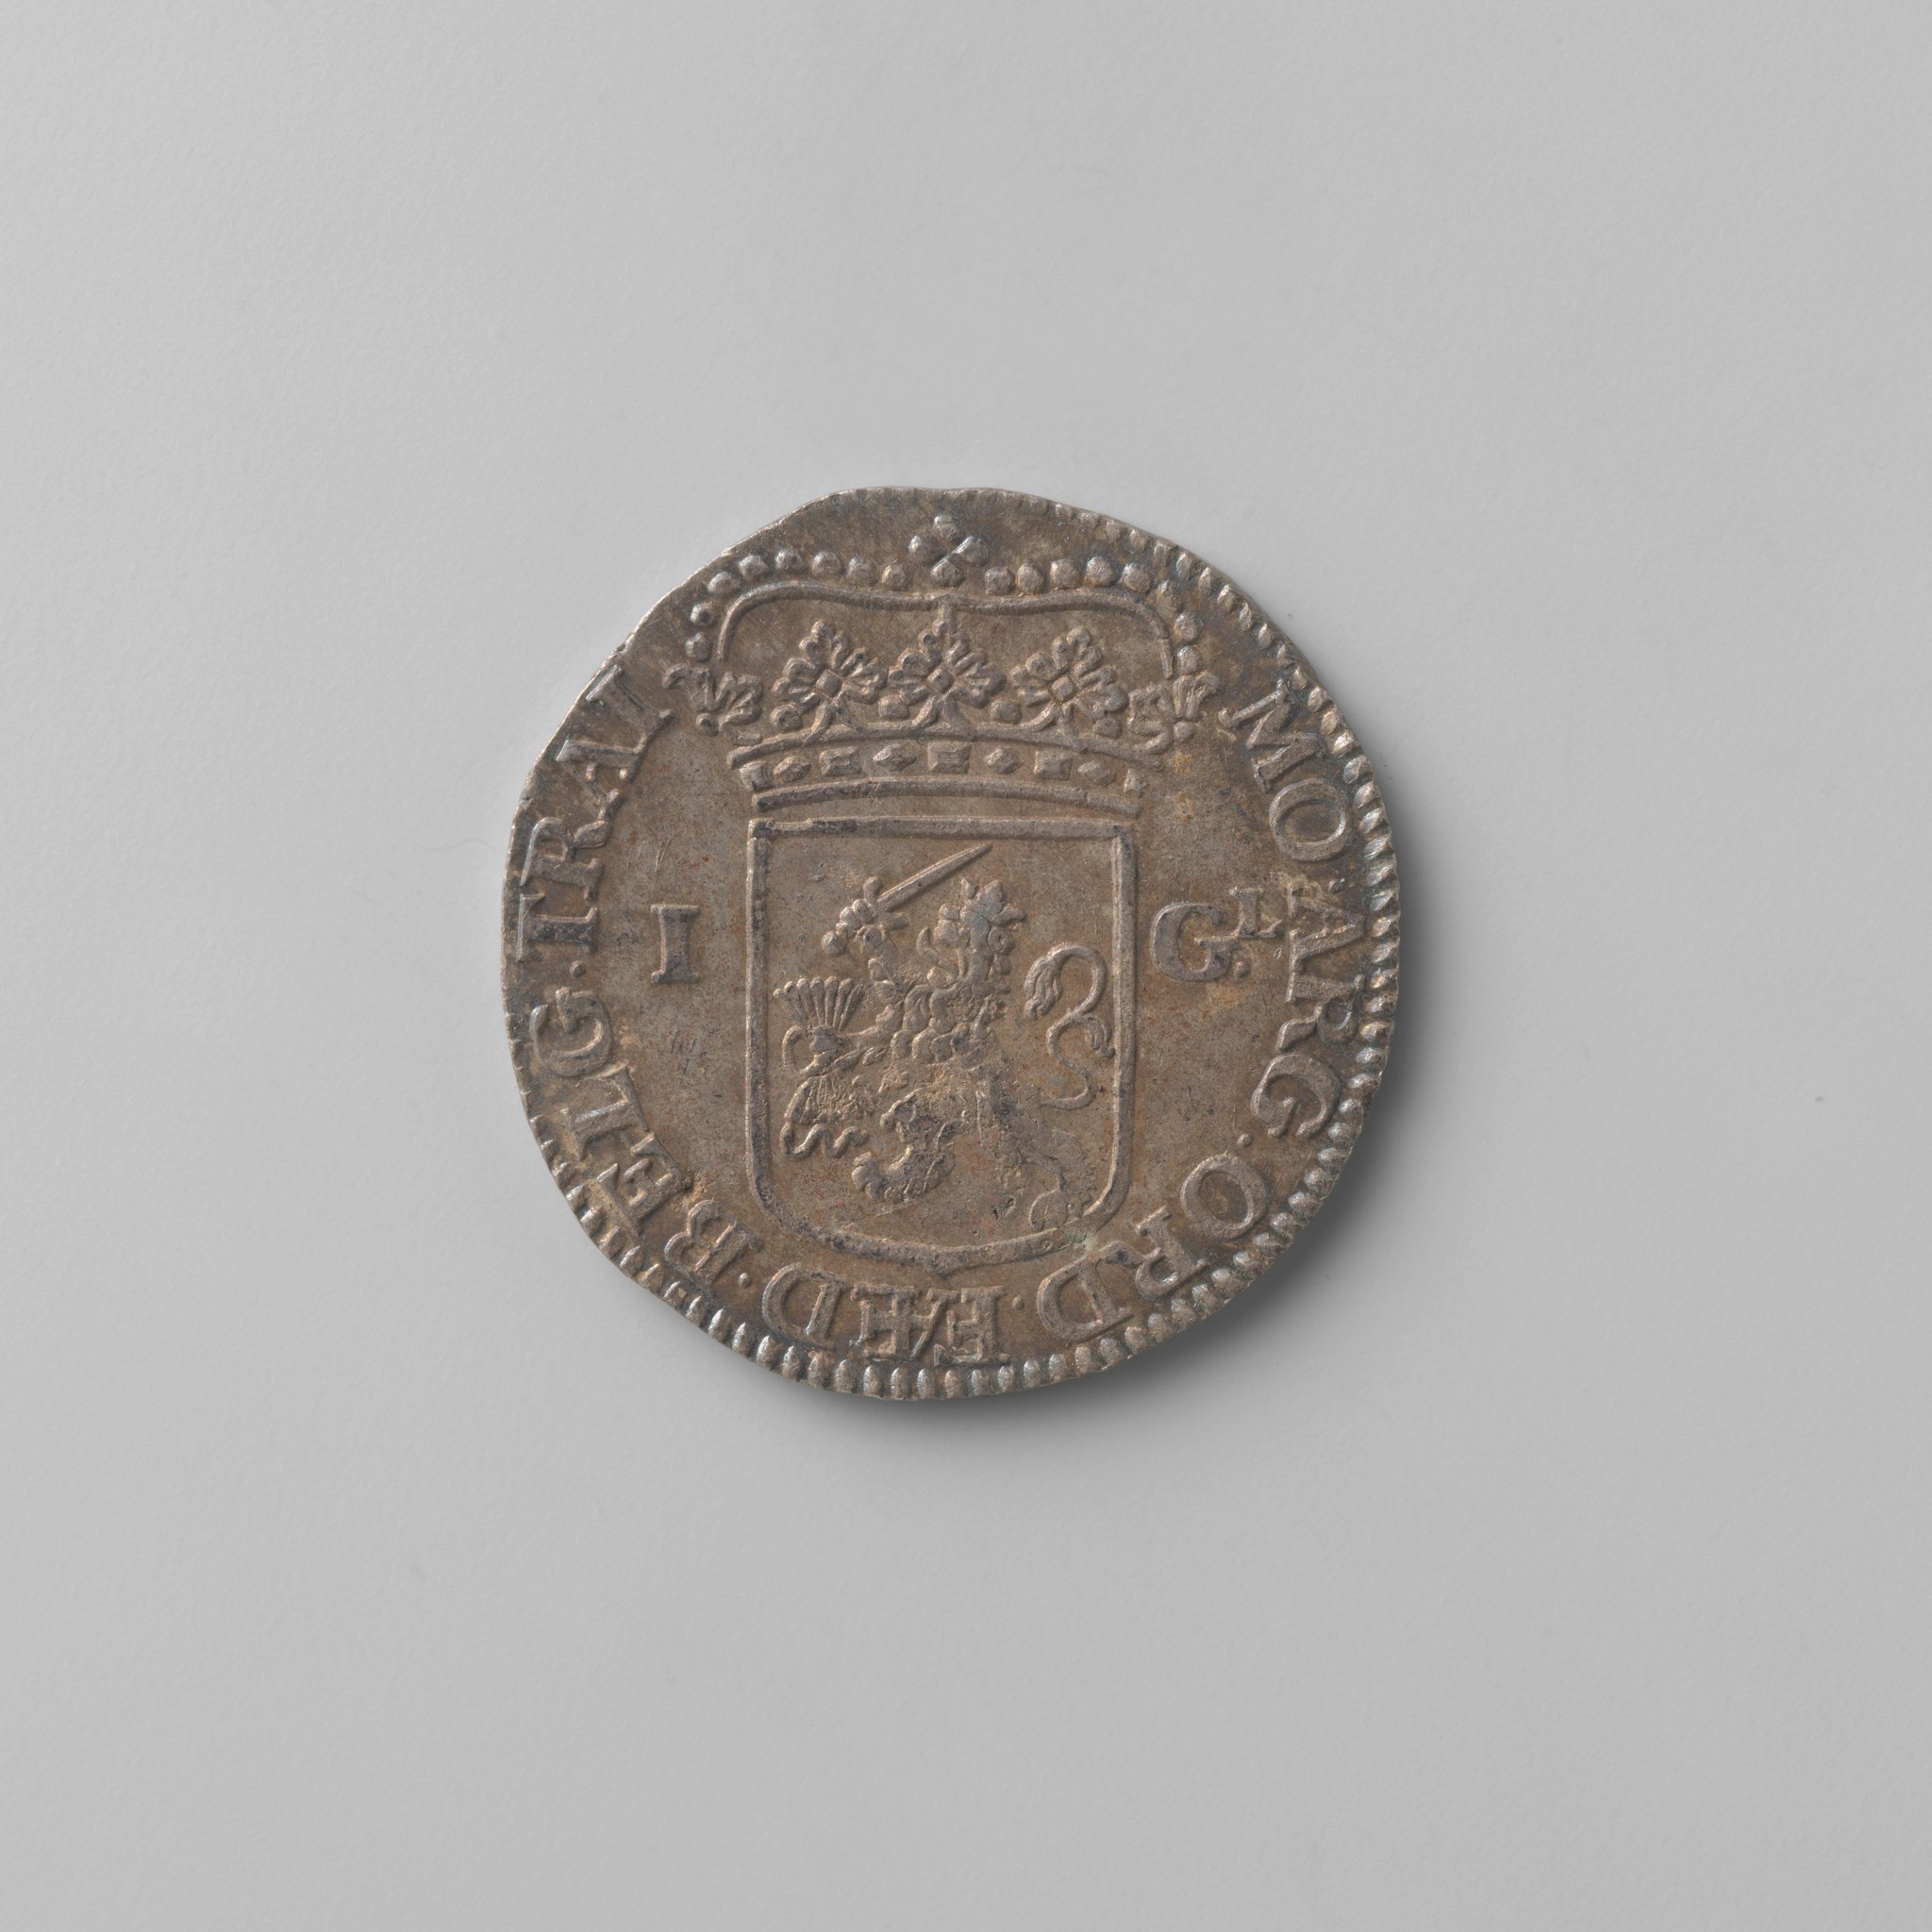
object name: coin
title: Utrechtse gulden, 1713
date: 1713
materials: silver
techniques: striking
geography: utrecht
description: Zilveren munt. Voorzijde: tussen waarde-aanduiding gekroond generaliteirtswapenschild. Keerzijde: Nederlandse maagd met vrijheidshoed en speer, leunend op een bijbel op een altaar. In afsnede jaartal.